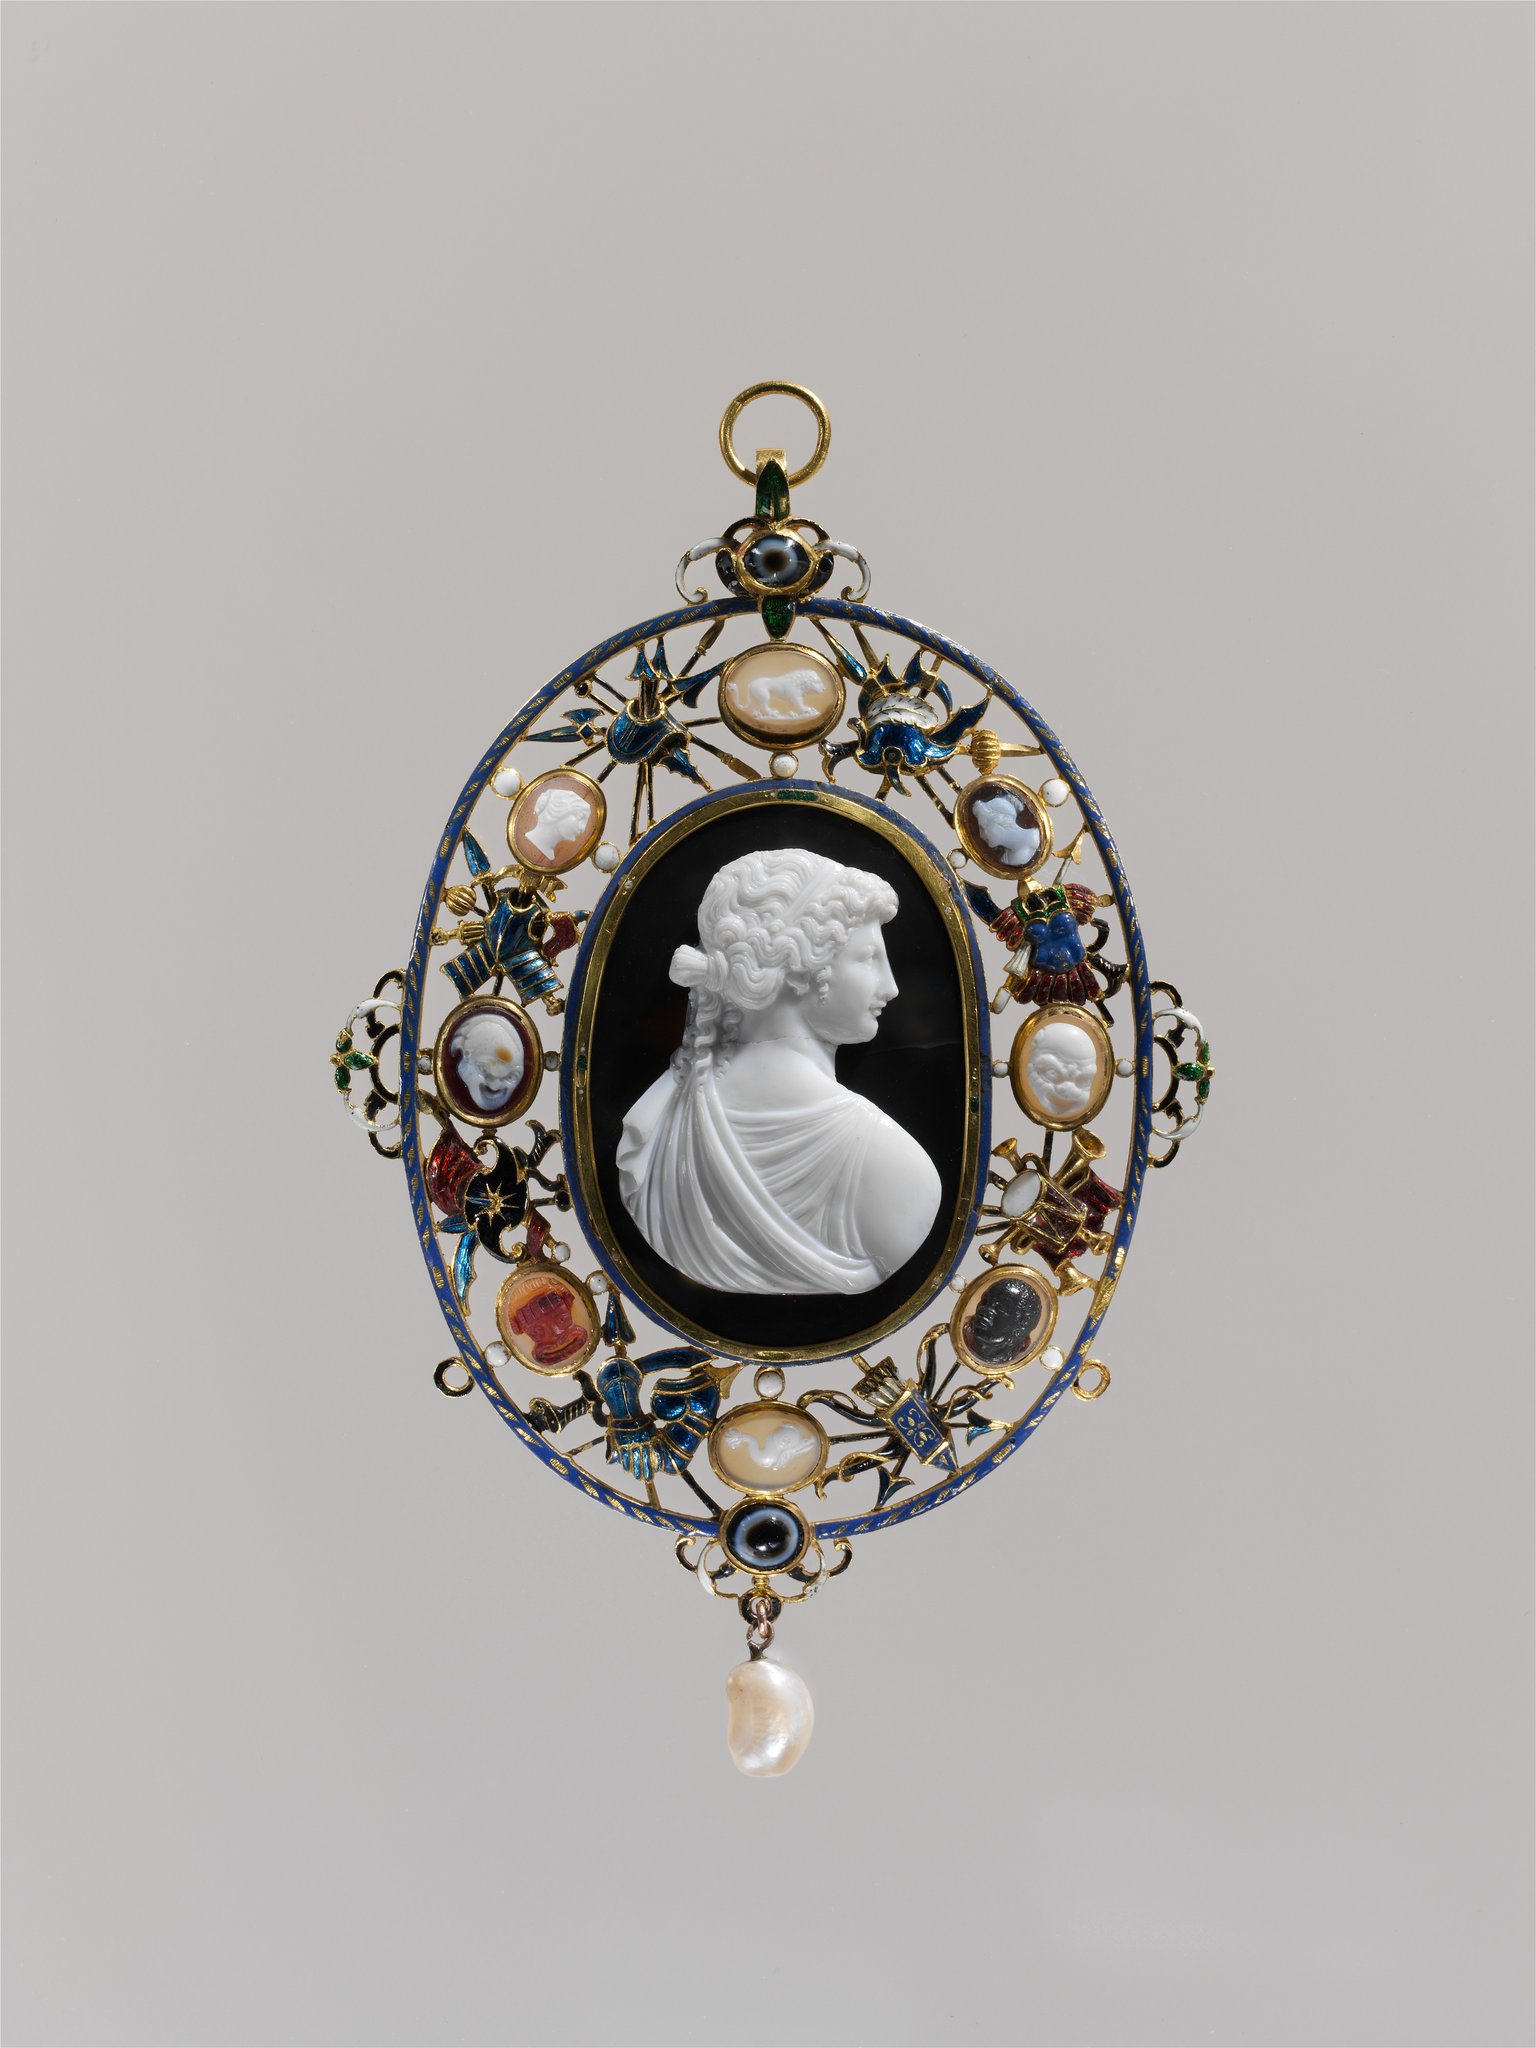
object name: pendant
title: A "Marlborough Gem": Bust of a woman in profile, her back to the spectator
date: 1801-1900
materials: enamel, gold, onyx, pearl, gemstone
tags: profiles,women